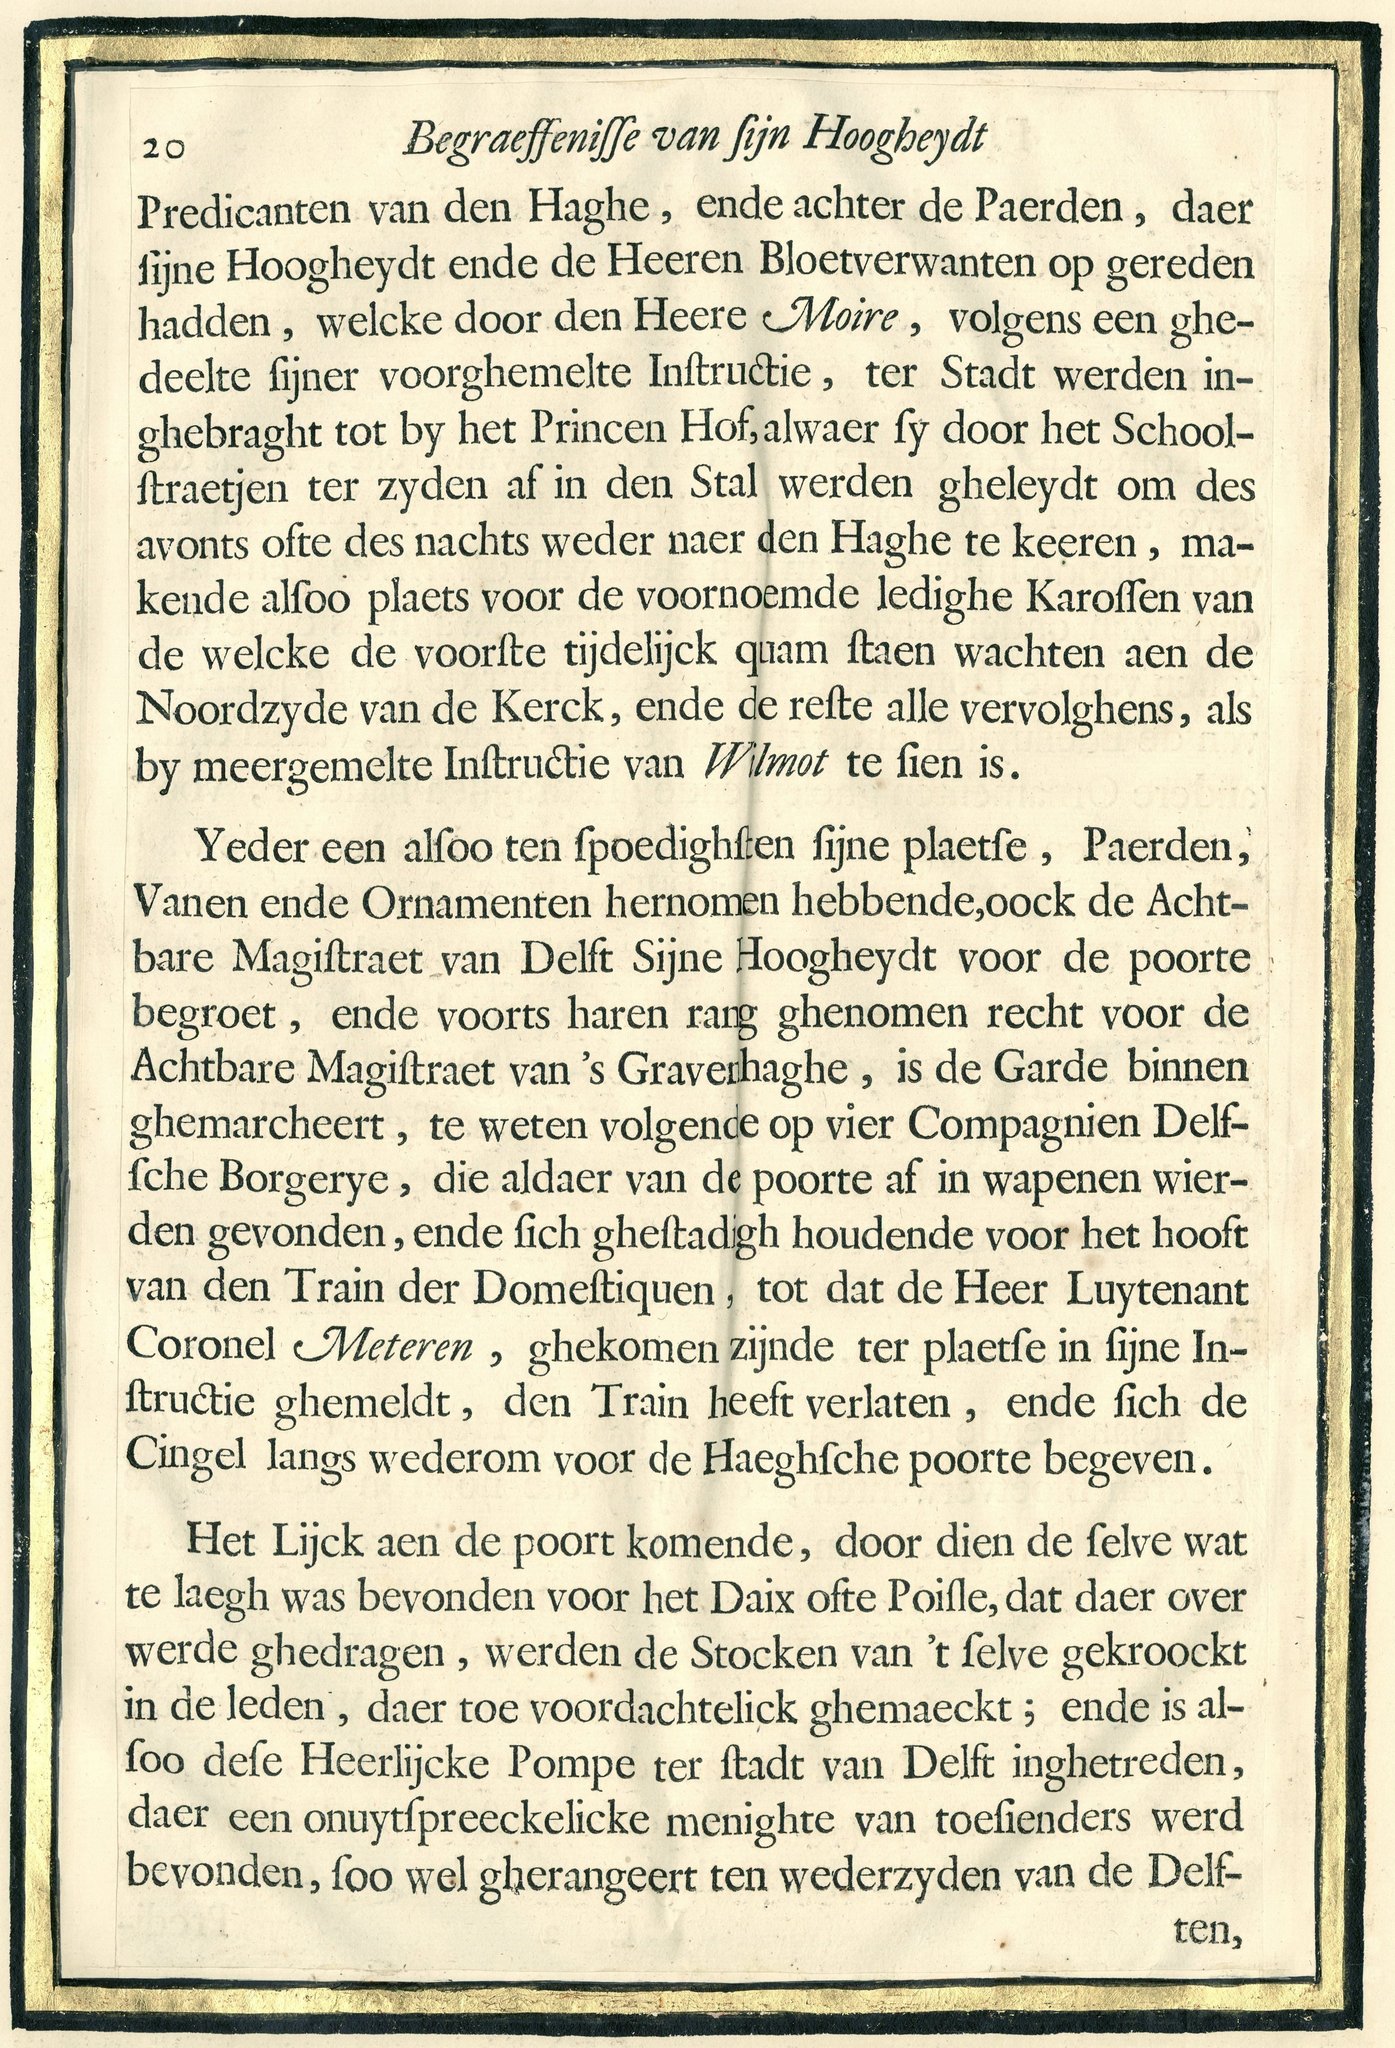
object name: book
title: De beschrijving van de begrafenis van Frederik Hendrik, p. 20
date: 1651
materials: paint, paper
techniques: letterpress printing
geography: amsterdam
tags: delft, frederick henry (prince of orange)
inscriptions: date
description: Pagina 20 van de beschrijving van de begrafenis van Frederik Hendrik. Blad uitgeknipt, versierd met goud en ingeplakt in de luxe editie uit ca. 1755 van het boek 'Begraeffenisse van syne hoogheyt Frederick Henrick' van Pieter Post, uitgegeven te Amsterdam in 1651.